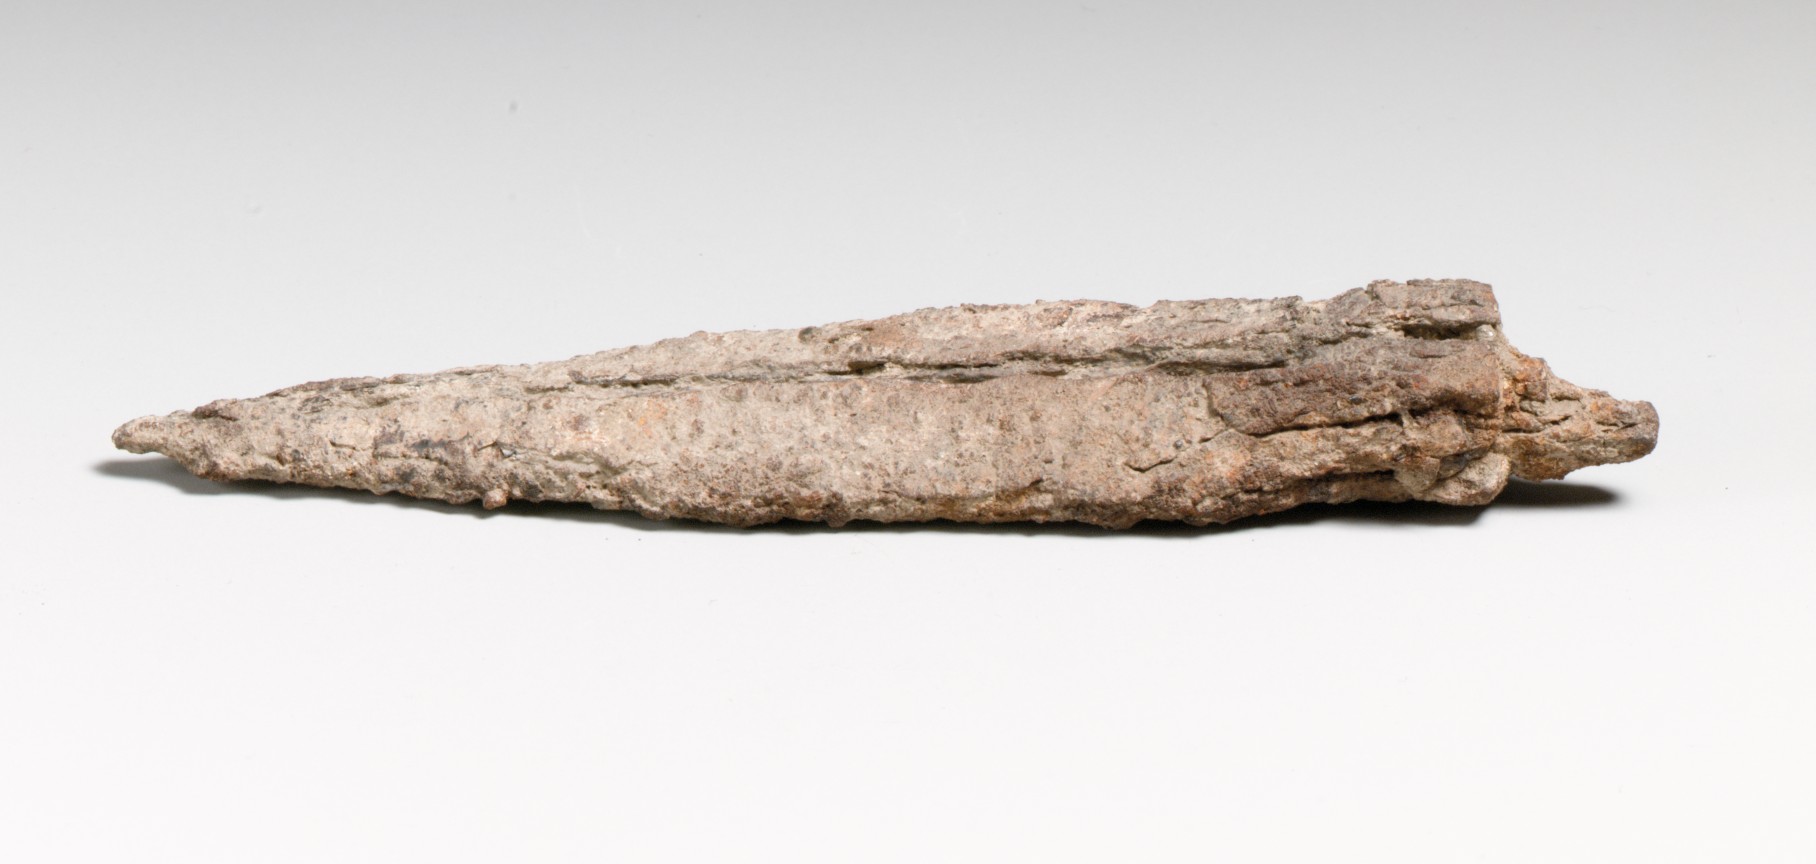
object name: spearhead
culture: cypriot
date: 1050-1000 BCE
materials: iron